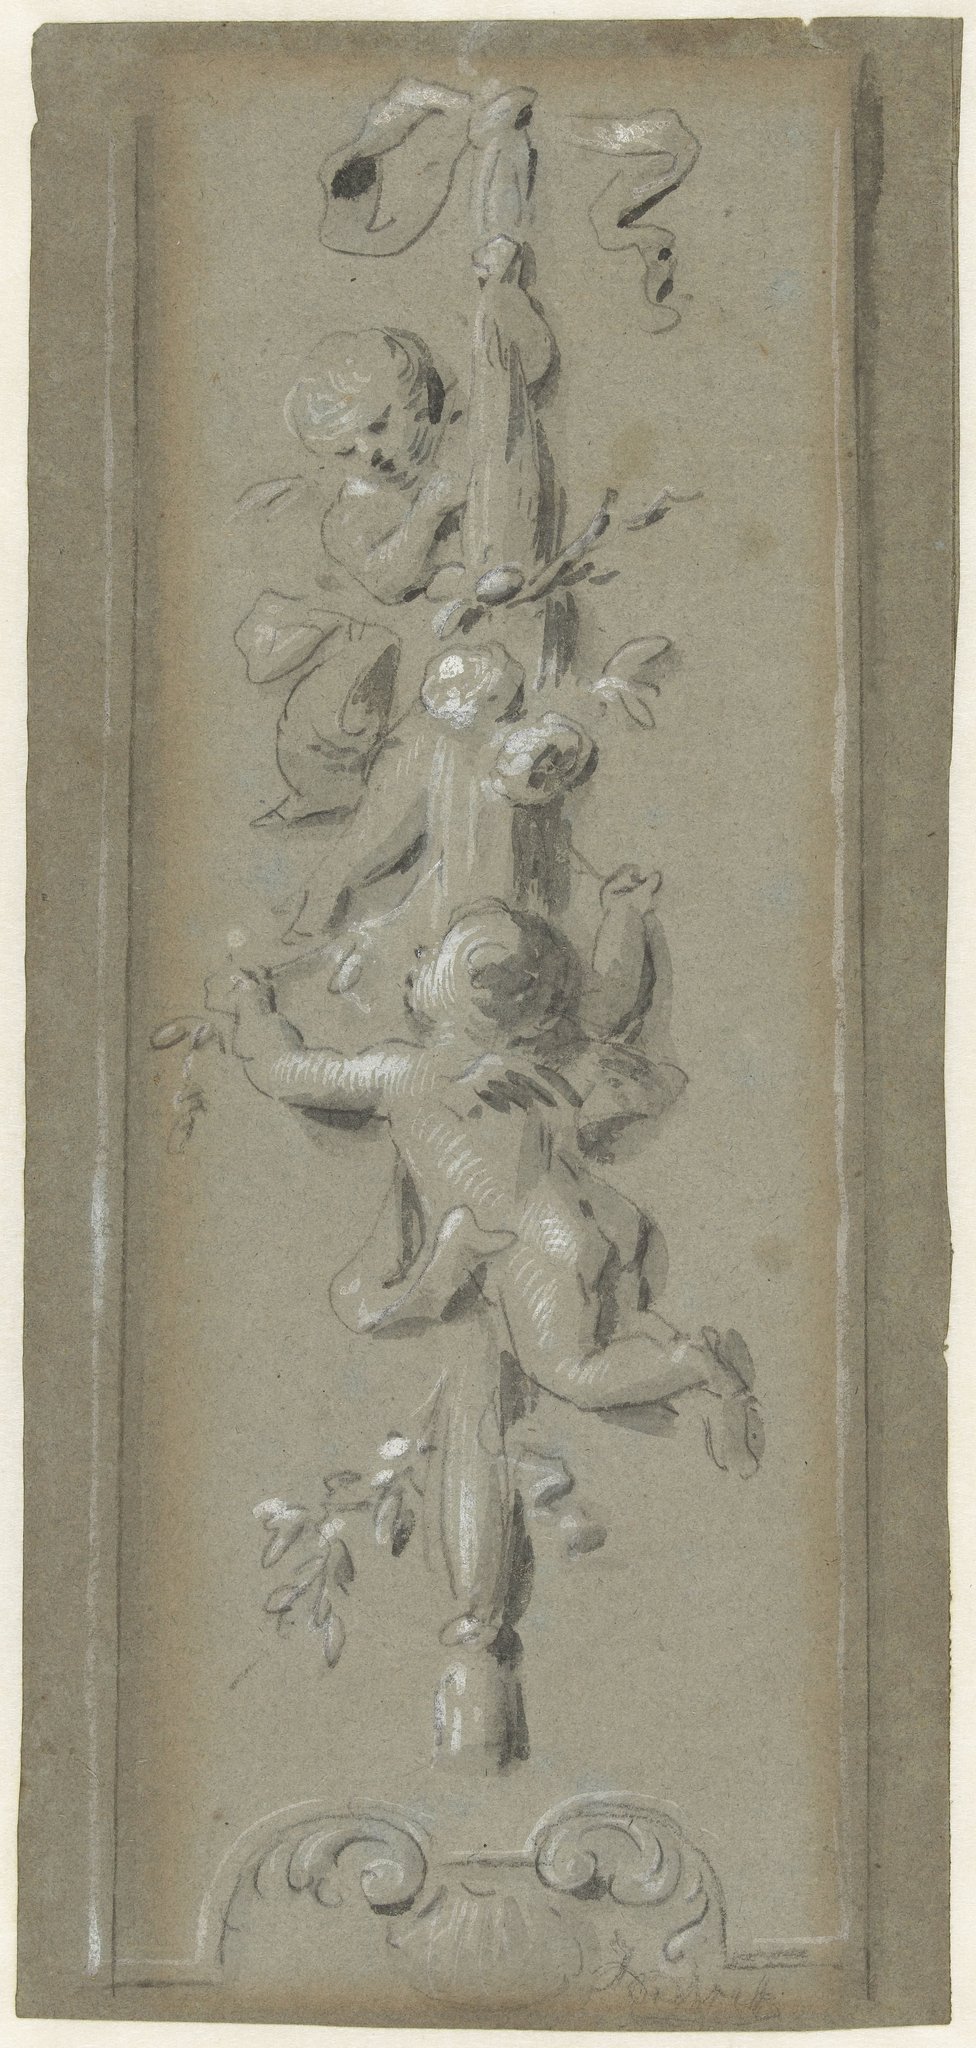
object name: design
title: Ontwerp voor een wandbespanning met twee putti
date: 1705-1804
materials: chalk, paint, ink, paper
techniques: brush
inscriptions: signature: ‘J de Wit’